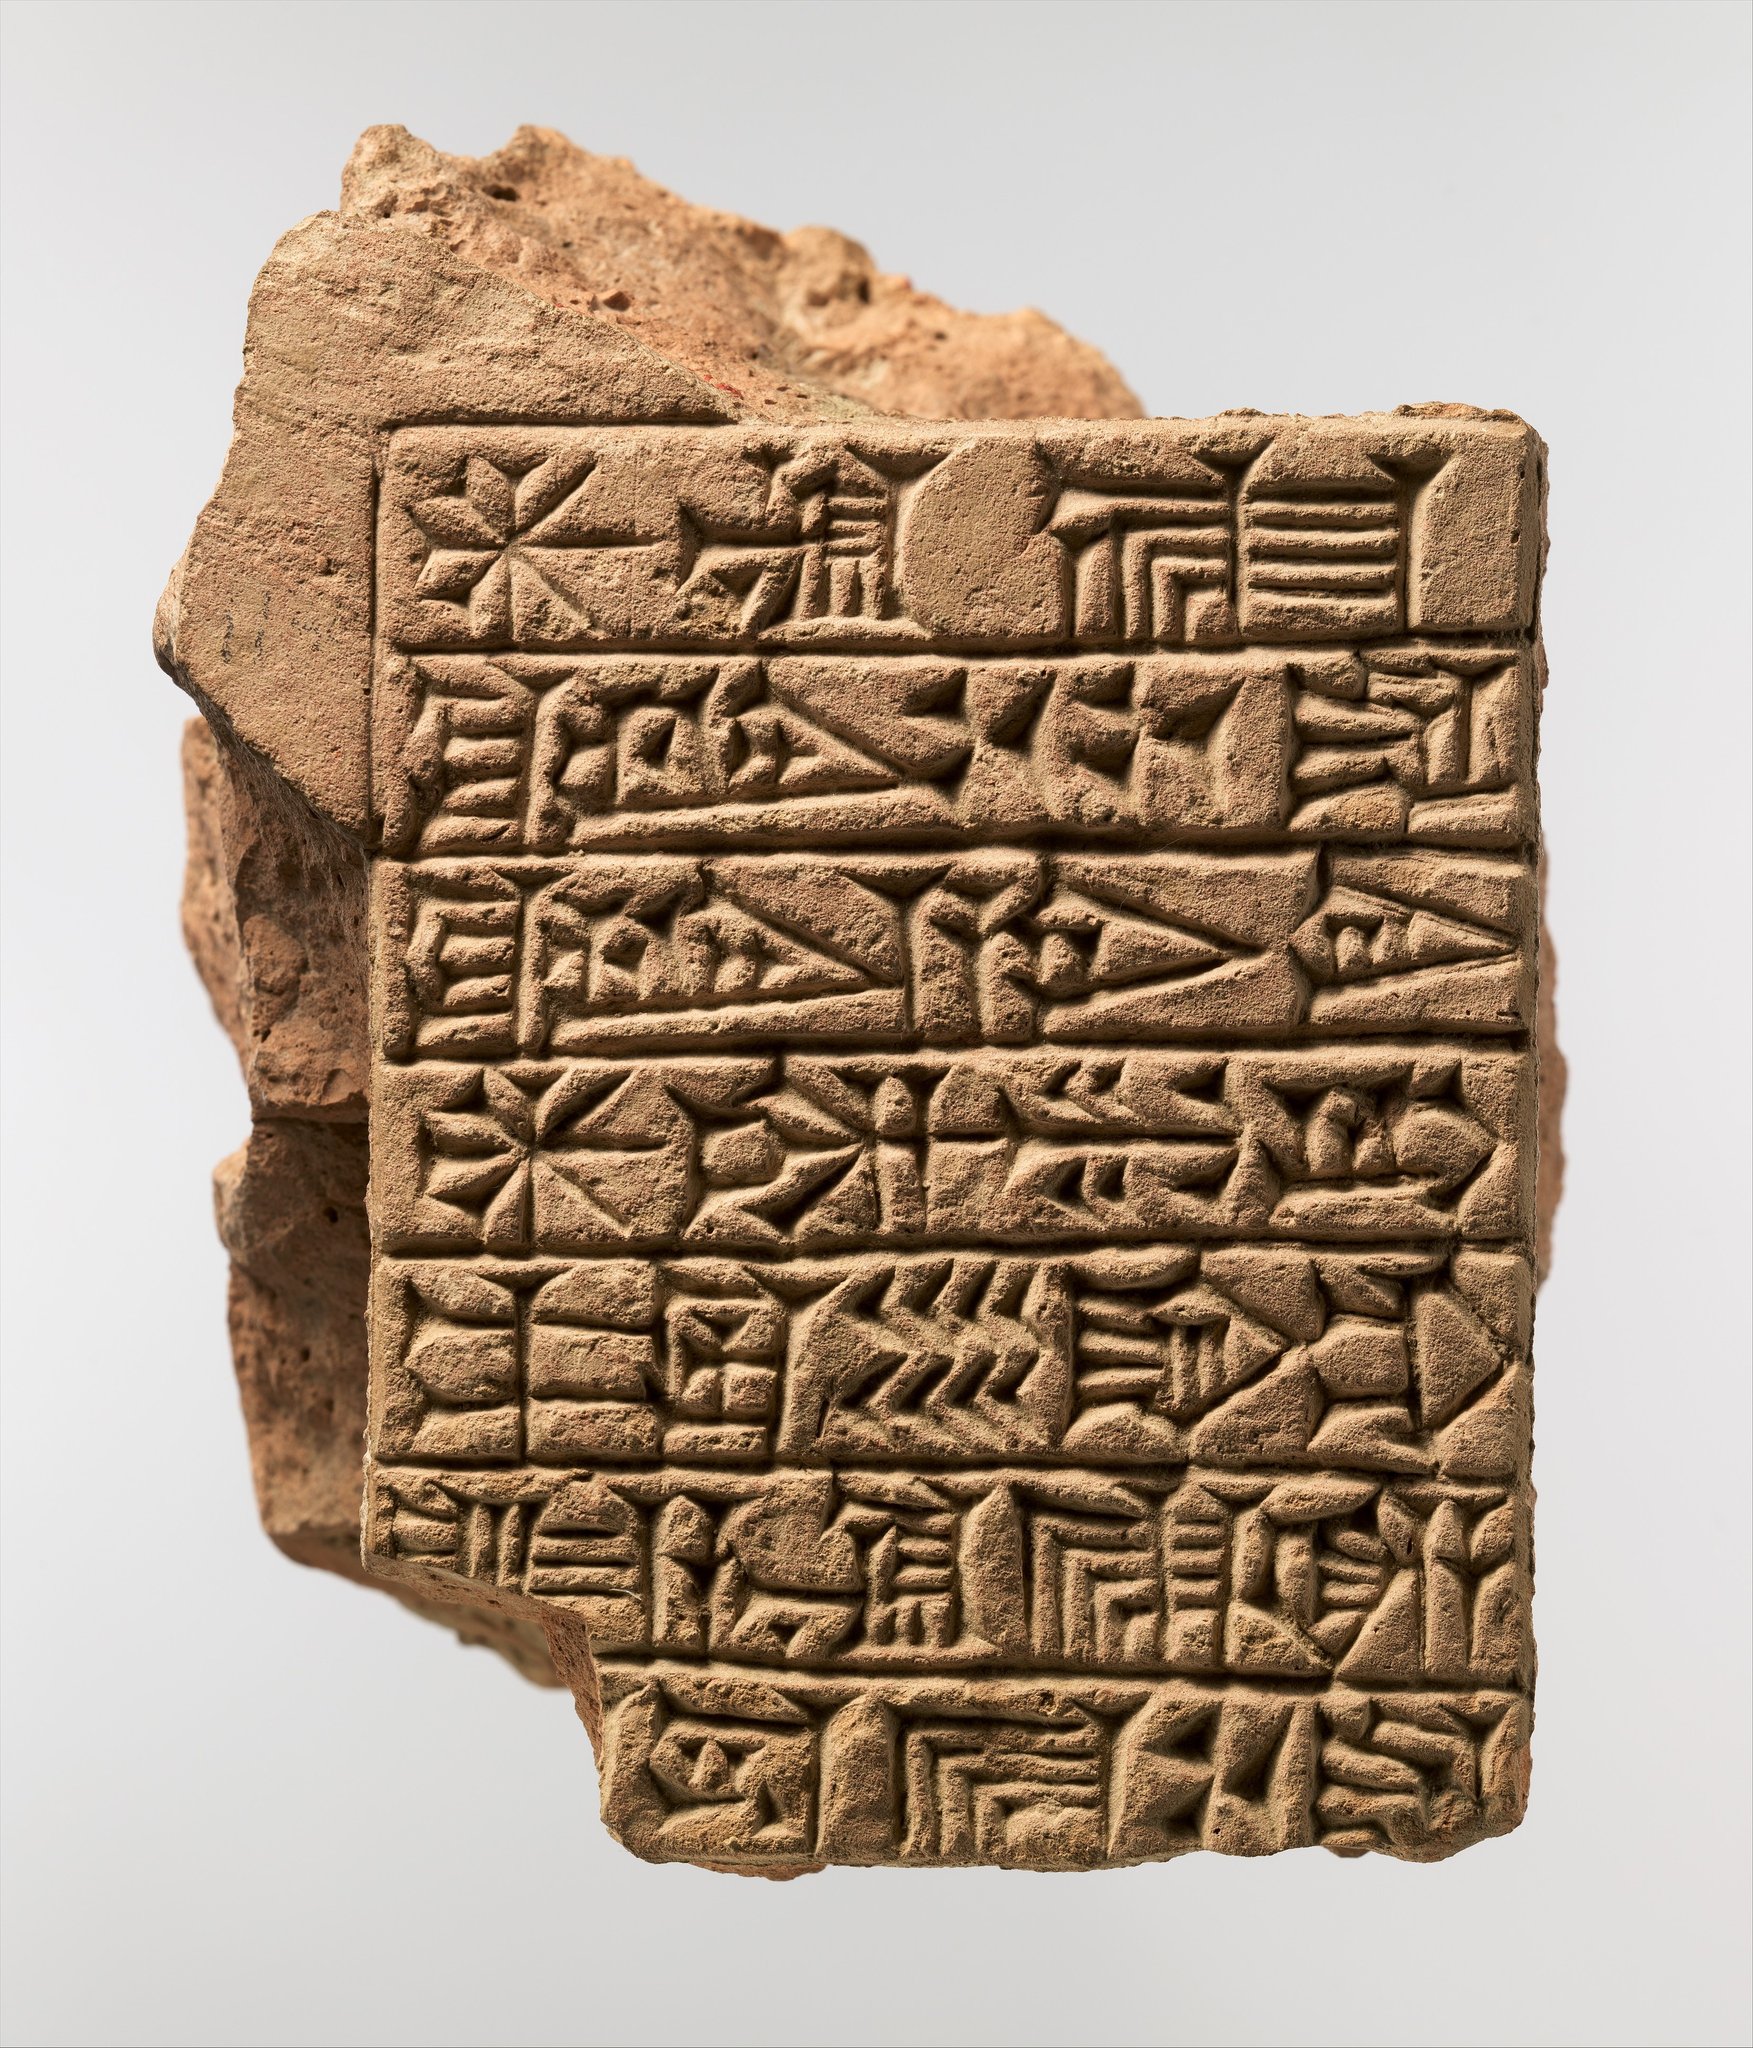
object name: brick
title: Inscribed brick: dedicatory inscription of Adad-shuma-usur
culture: kassite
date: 1216-1187 BCE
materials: ceramic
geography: mesopotamia